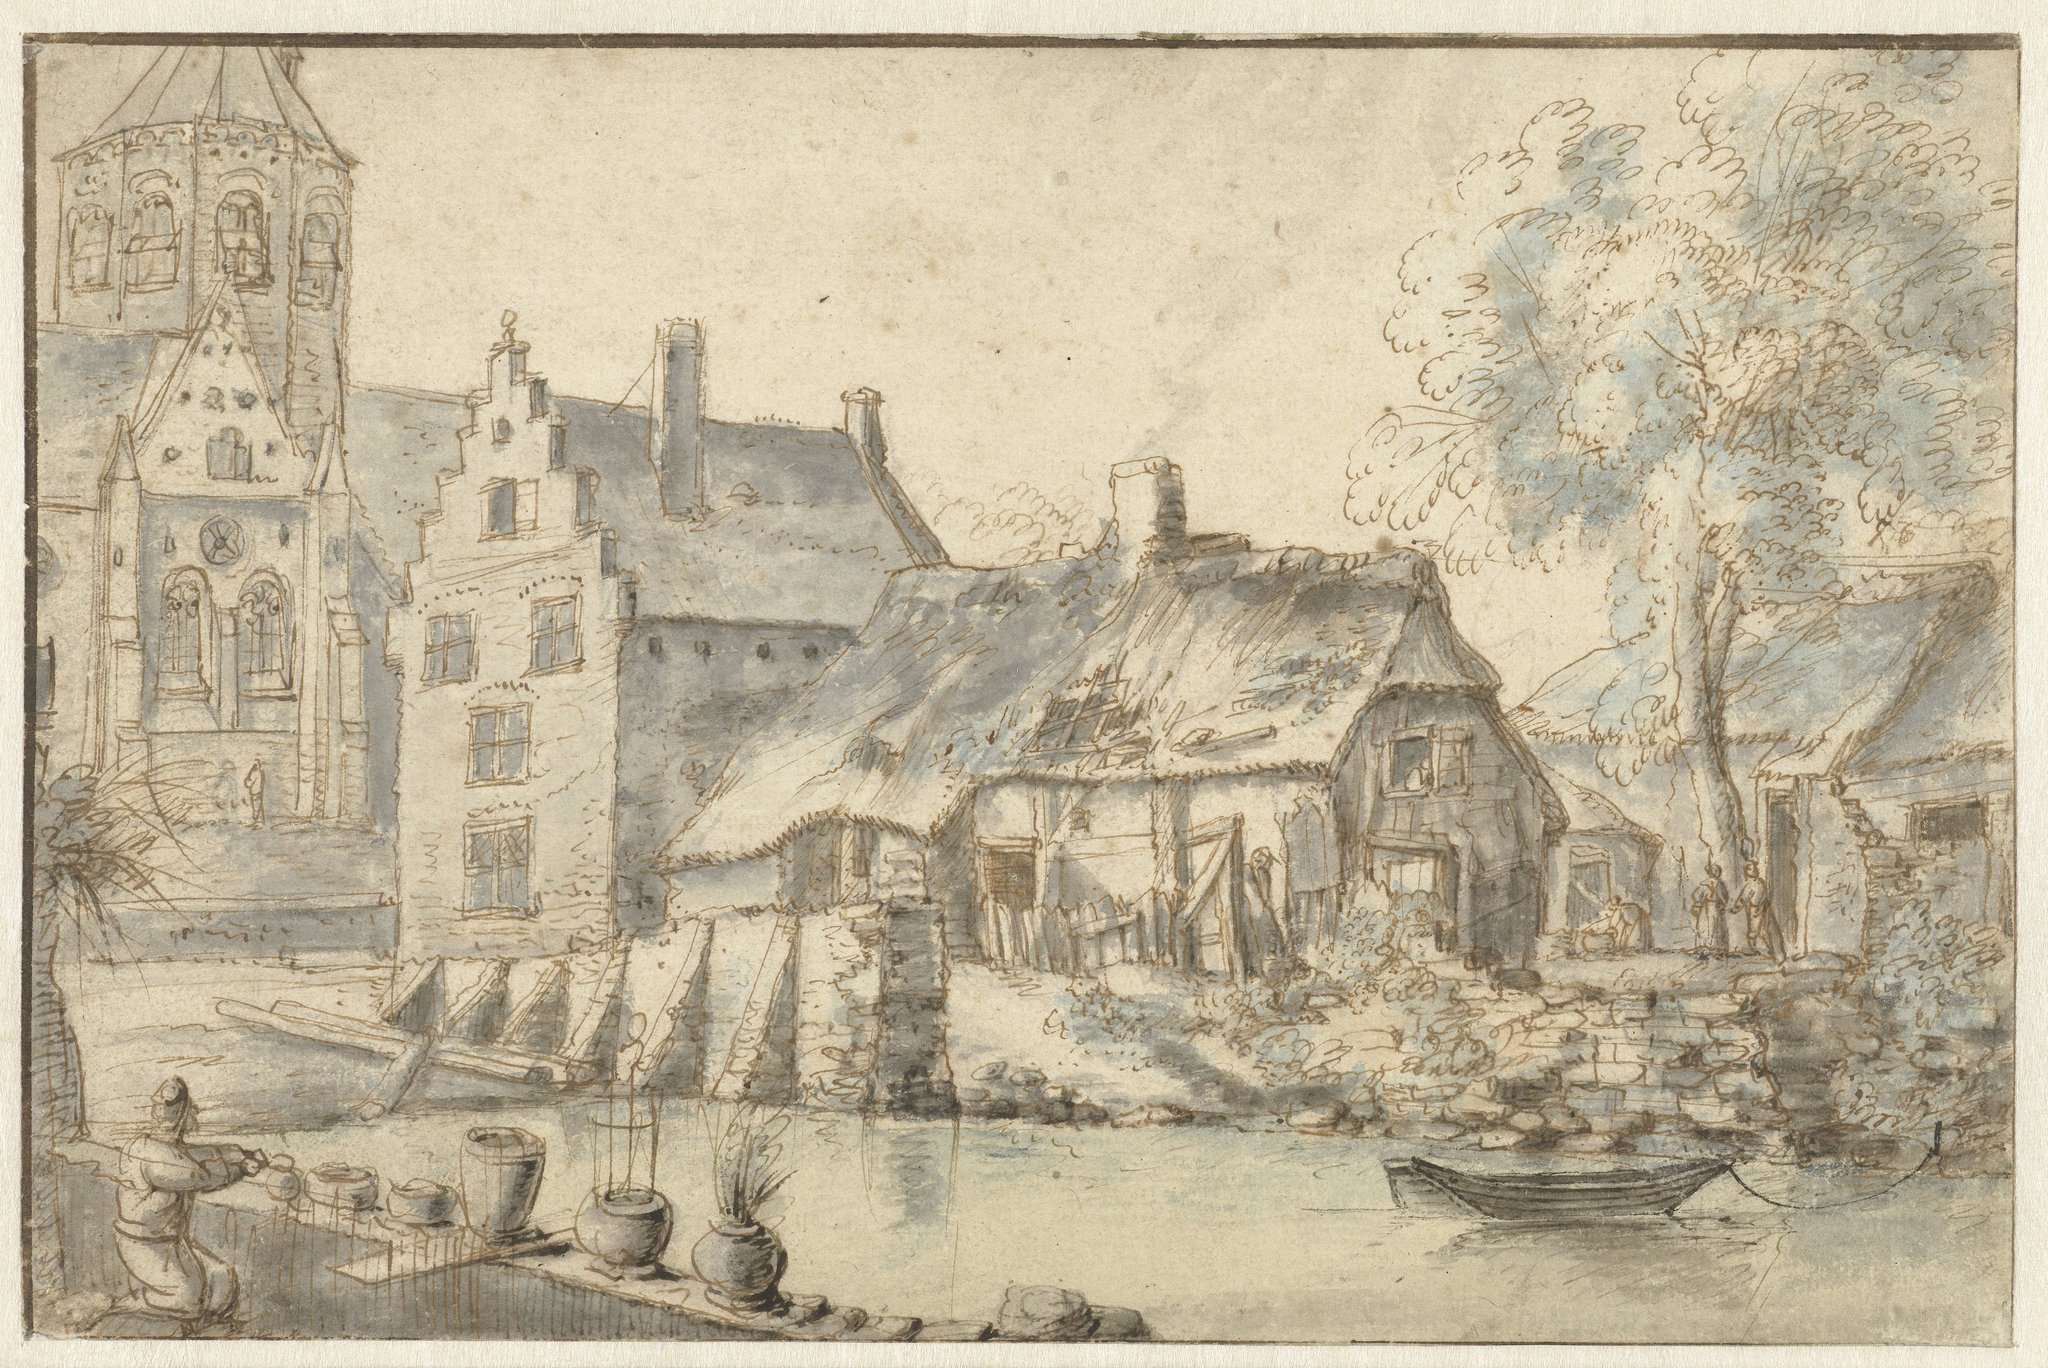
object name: drawing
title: Stadsgezicht met een grote kerk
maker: Anonymous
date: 1600-1699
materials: graphite, ink, paper, watercolor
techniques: brush, pen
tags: church (exterior), canals, waters (in city)